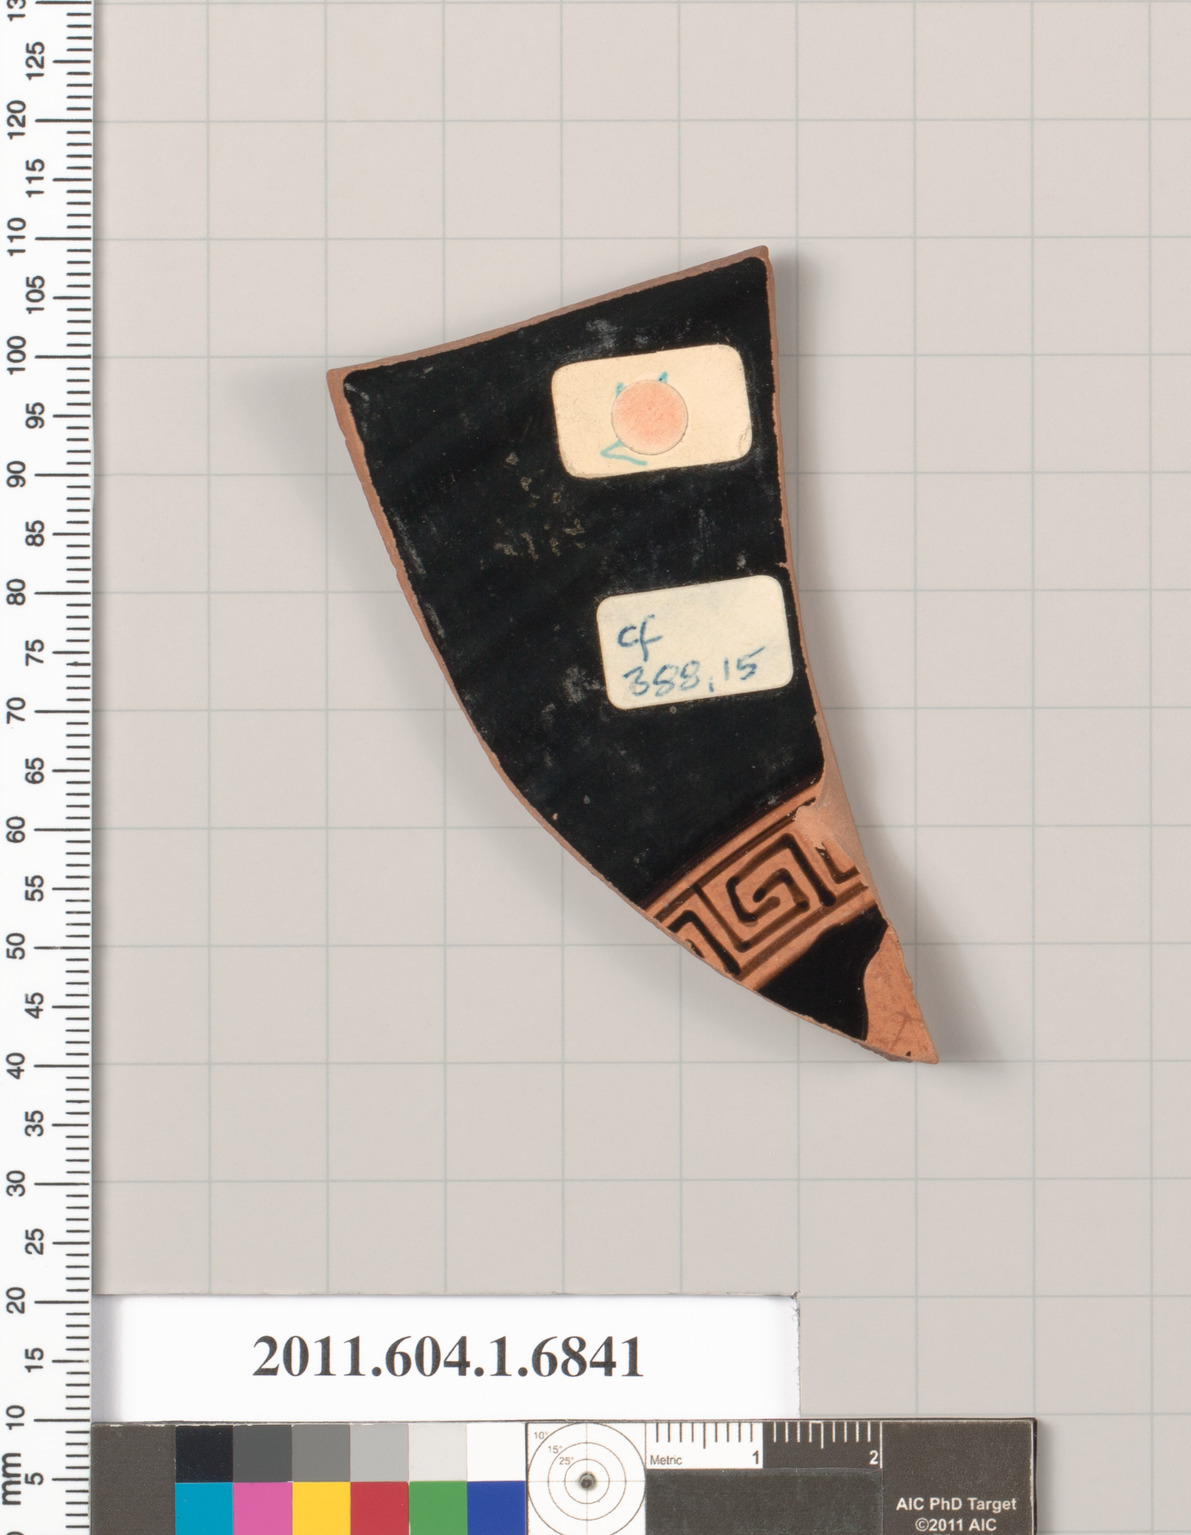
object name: kylix fragment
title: Terracotta fragment of a kylix (drinking cup)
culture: greek, attic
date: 490-470 BCE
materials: terracotta